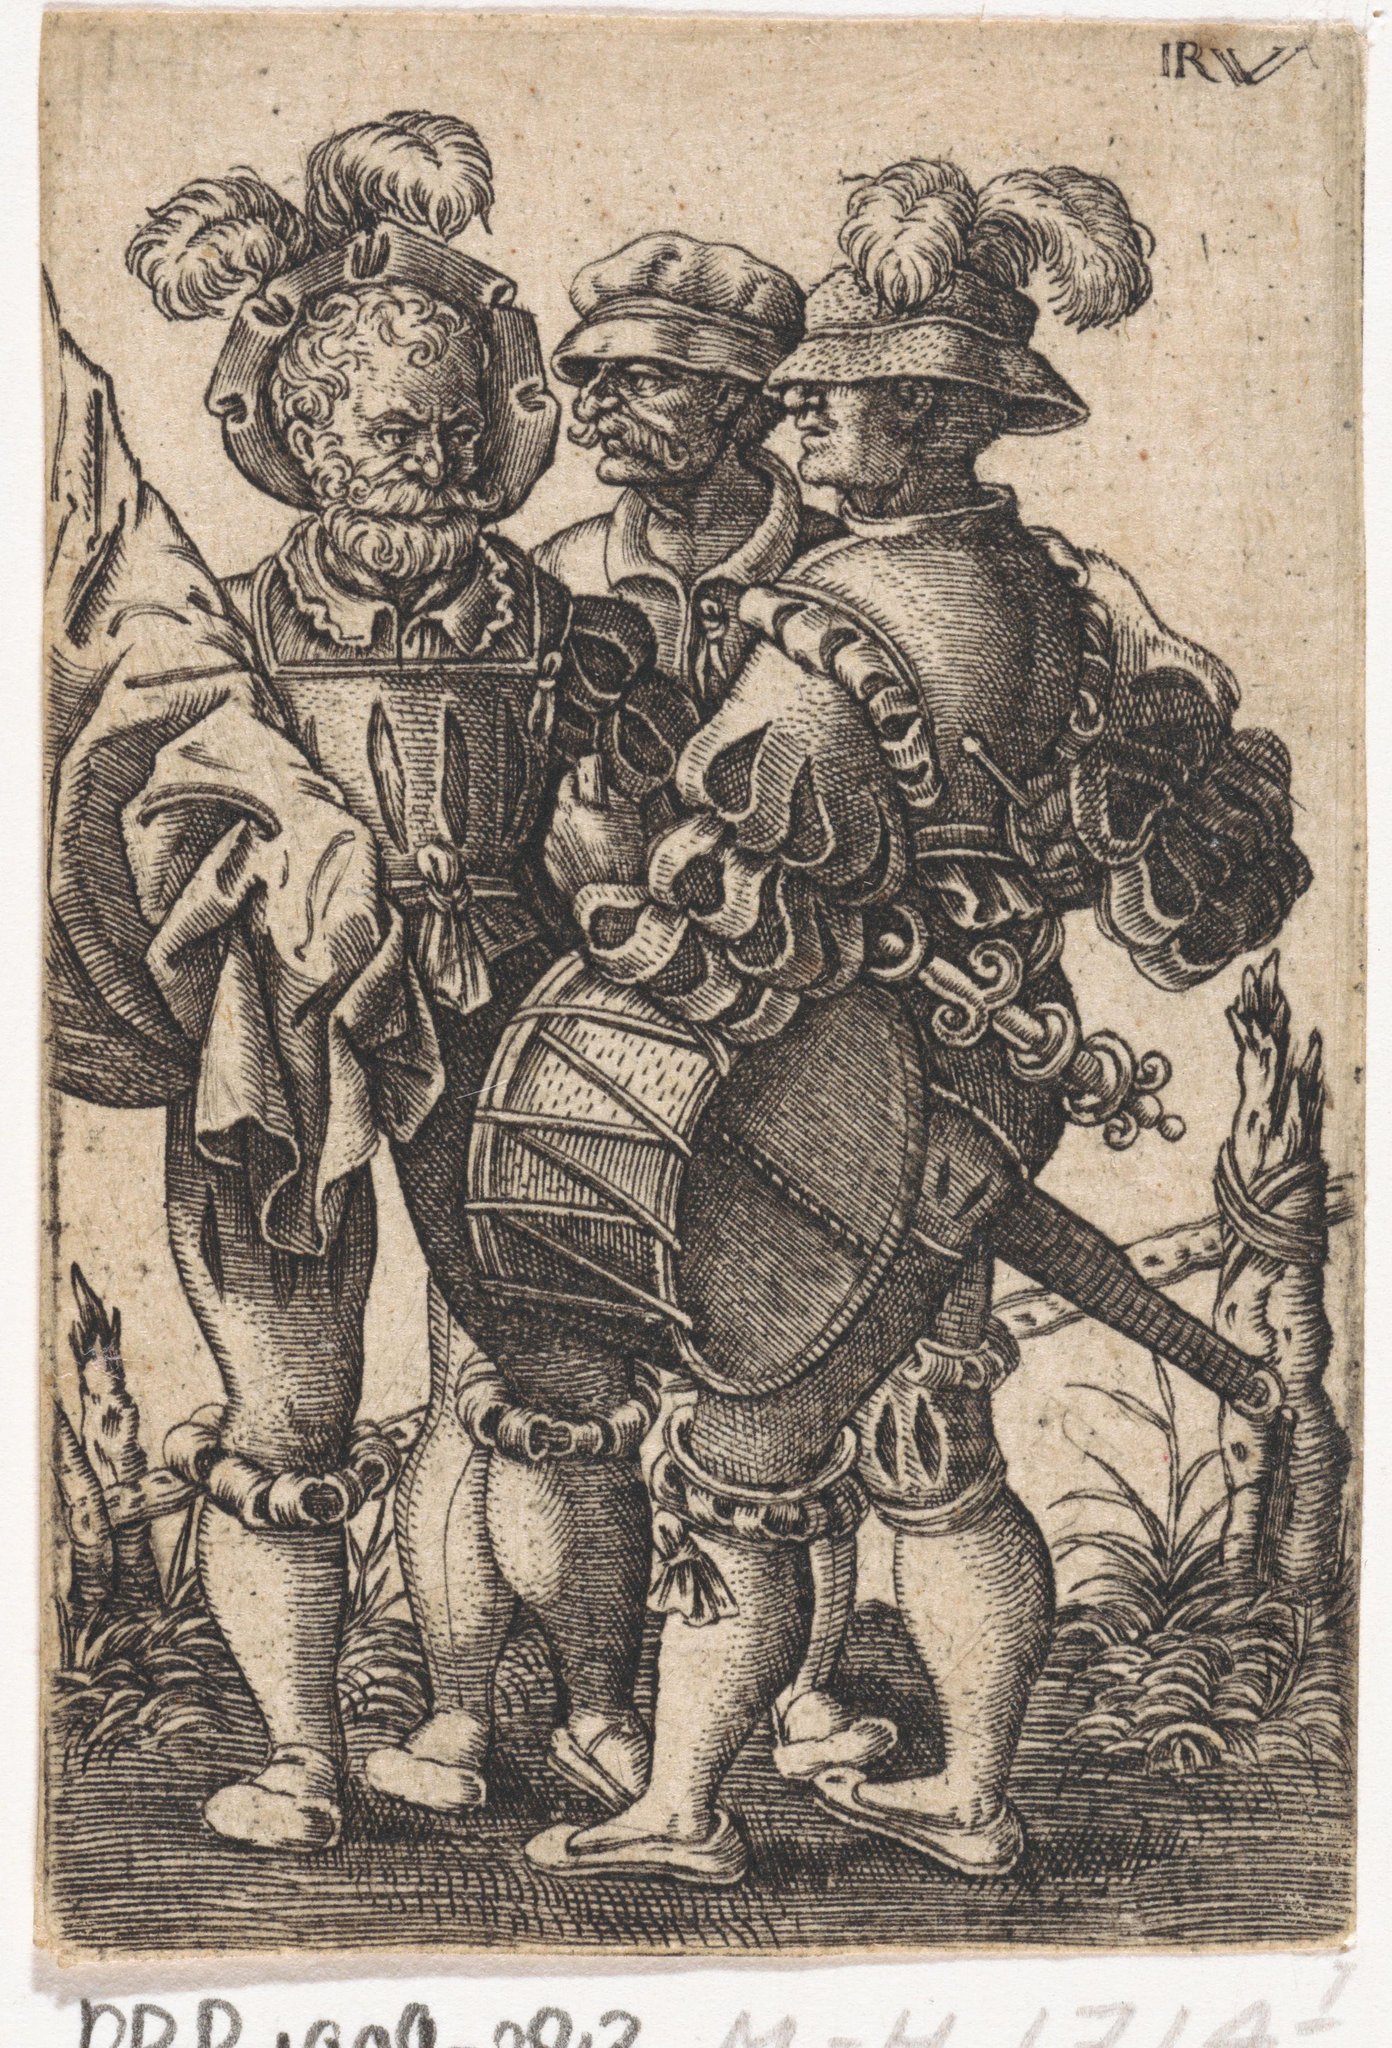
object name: print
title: Vaandeldrager, tamboer en een derde man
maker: hieronymus wierix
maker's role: draughtsman, print maker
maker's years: 1553-1619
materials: paper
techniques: engraving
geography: antwerp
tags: standard-bearer, flag-bearer, tambourine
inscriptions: collector's mark: Lugt 2773, collector's mark: Lugt 2228